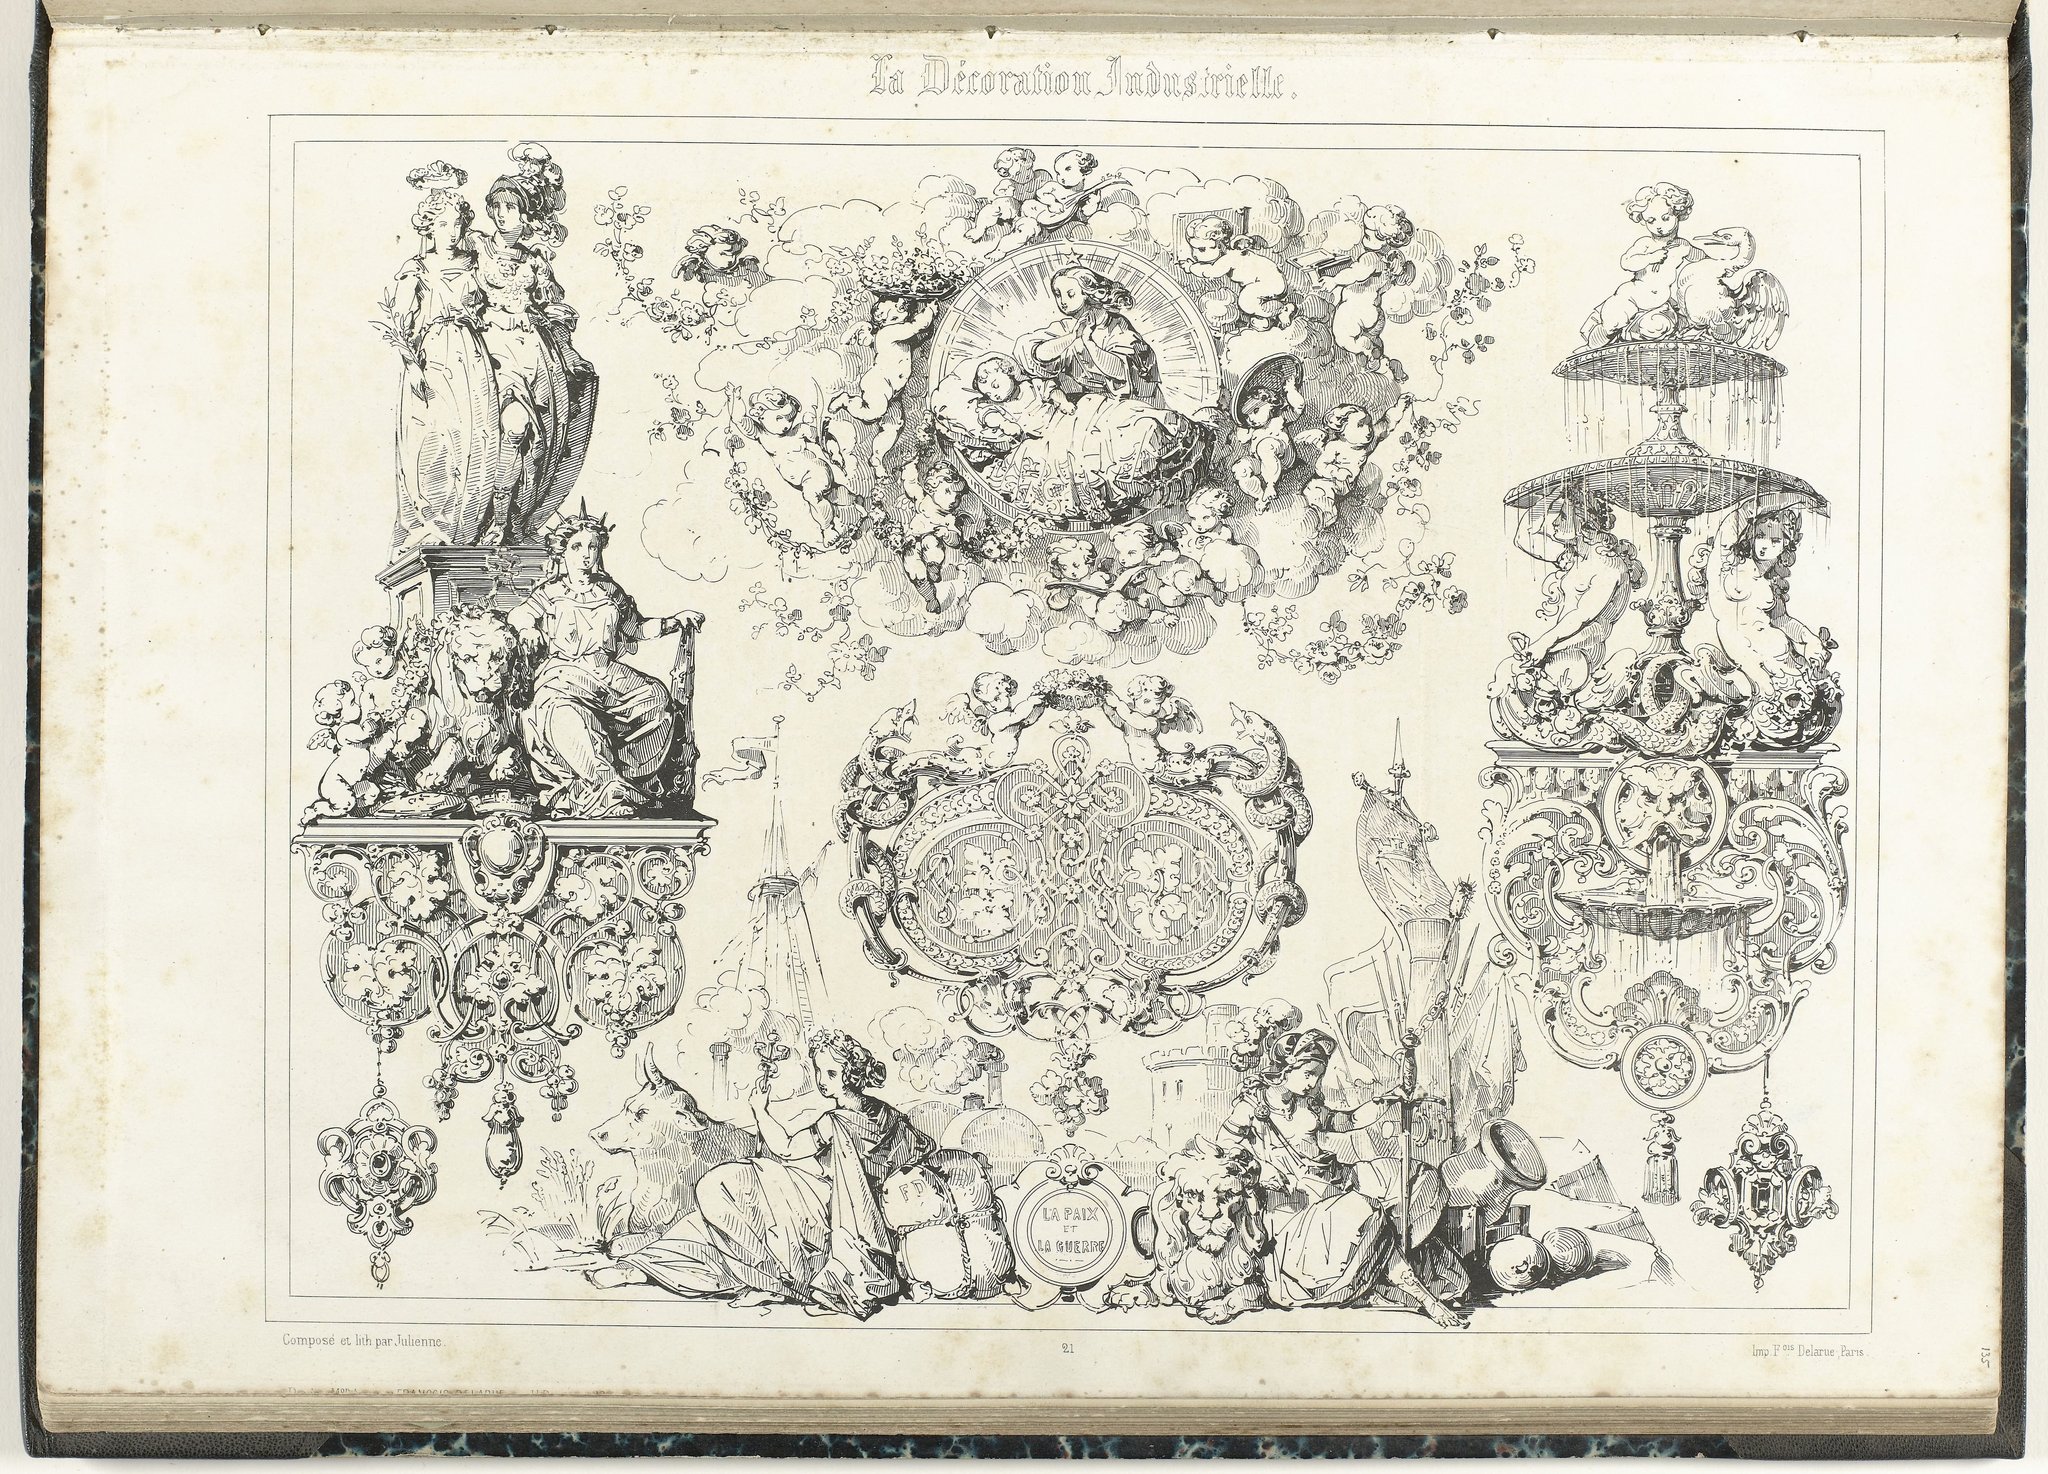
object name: print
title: Vrede en Oorlog zittend onder vier ornamenten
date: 1866-1900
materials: paper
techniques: lithograph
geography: paris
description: Linksboven staan Vrede en Oorlog op een voetstuk, rechts staat een fontein afgebeeld met bovenaan een putto die een zwaan voert. Rechtsonder: 21.